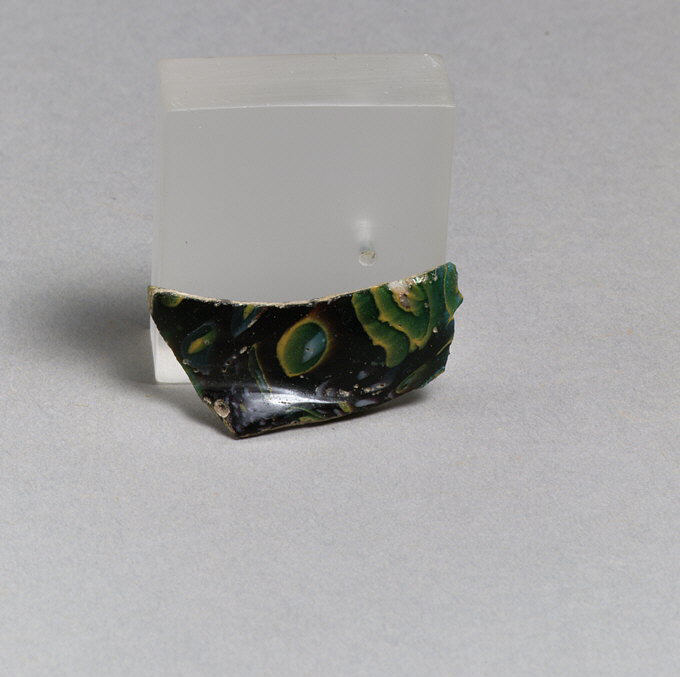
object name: fragment, mosaic bowl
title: Glass mosaic carinated bowl fragment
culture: roman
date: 34 BCE-33 CE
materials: glass